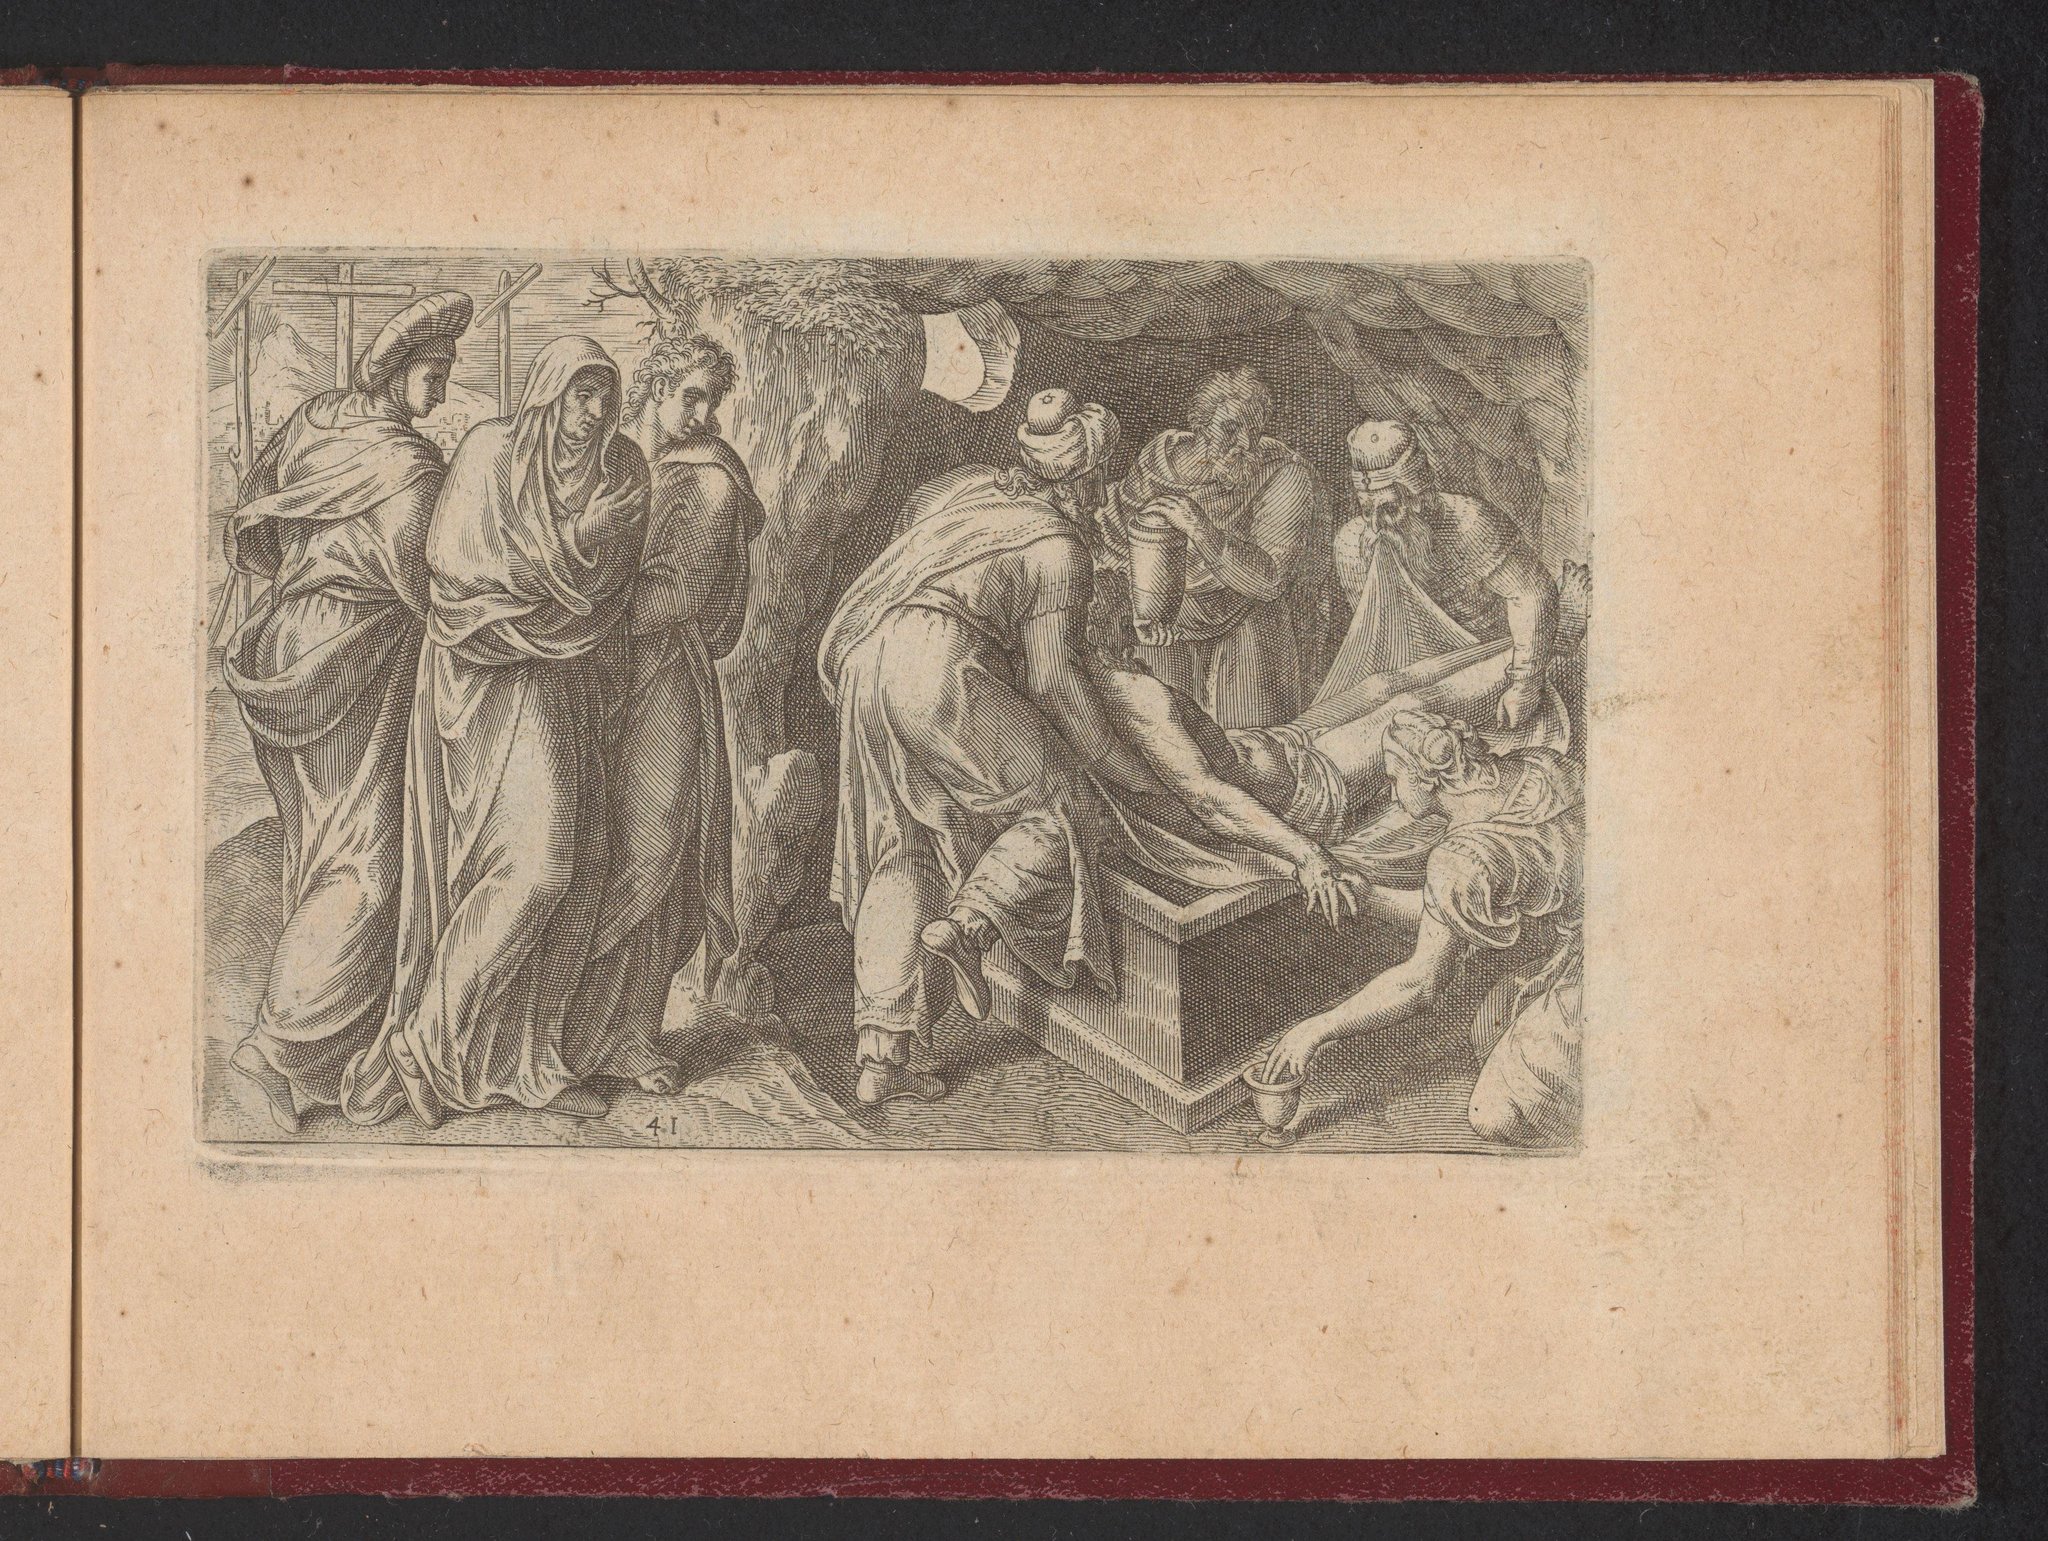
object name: print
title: Graflegging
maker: philips galle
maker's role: print maker, publisher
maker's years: 1537-1612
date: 1573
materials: paper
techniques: engraving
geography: antwerp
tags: christ's entombment (possibly by angels)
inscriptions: watermark: ‘gotische letter P’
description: Onderdeel van een album met een titelprent en een serie van 50 prenten betreffende het leven en de passie van Christus.